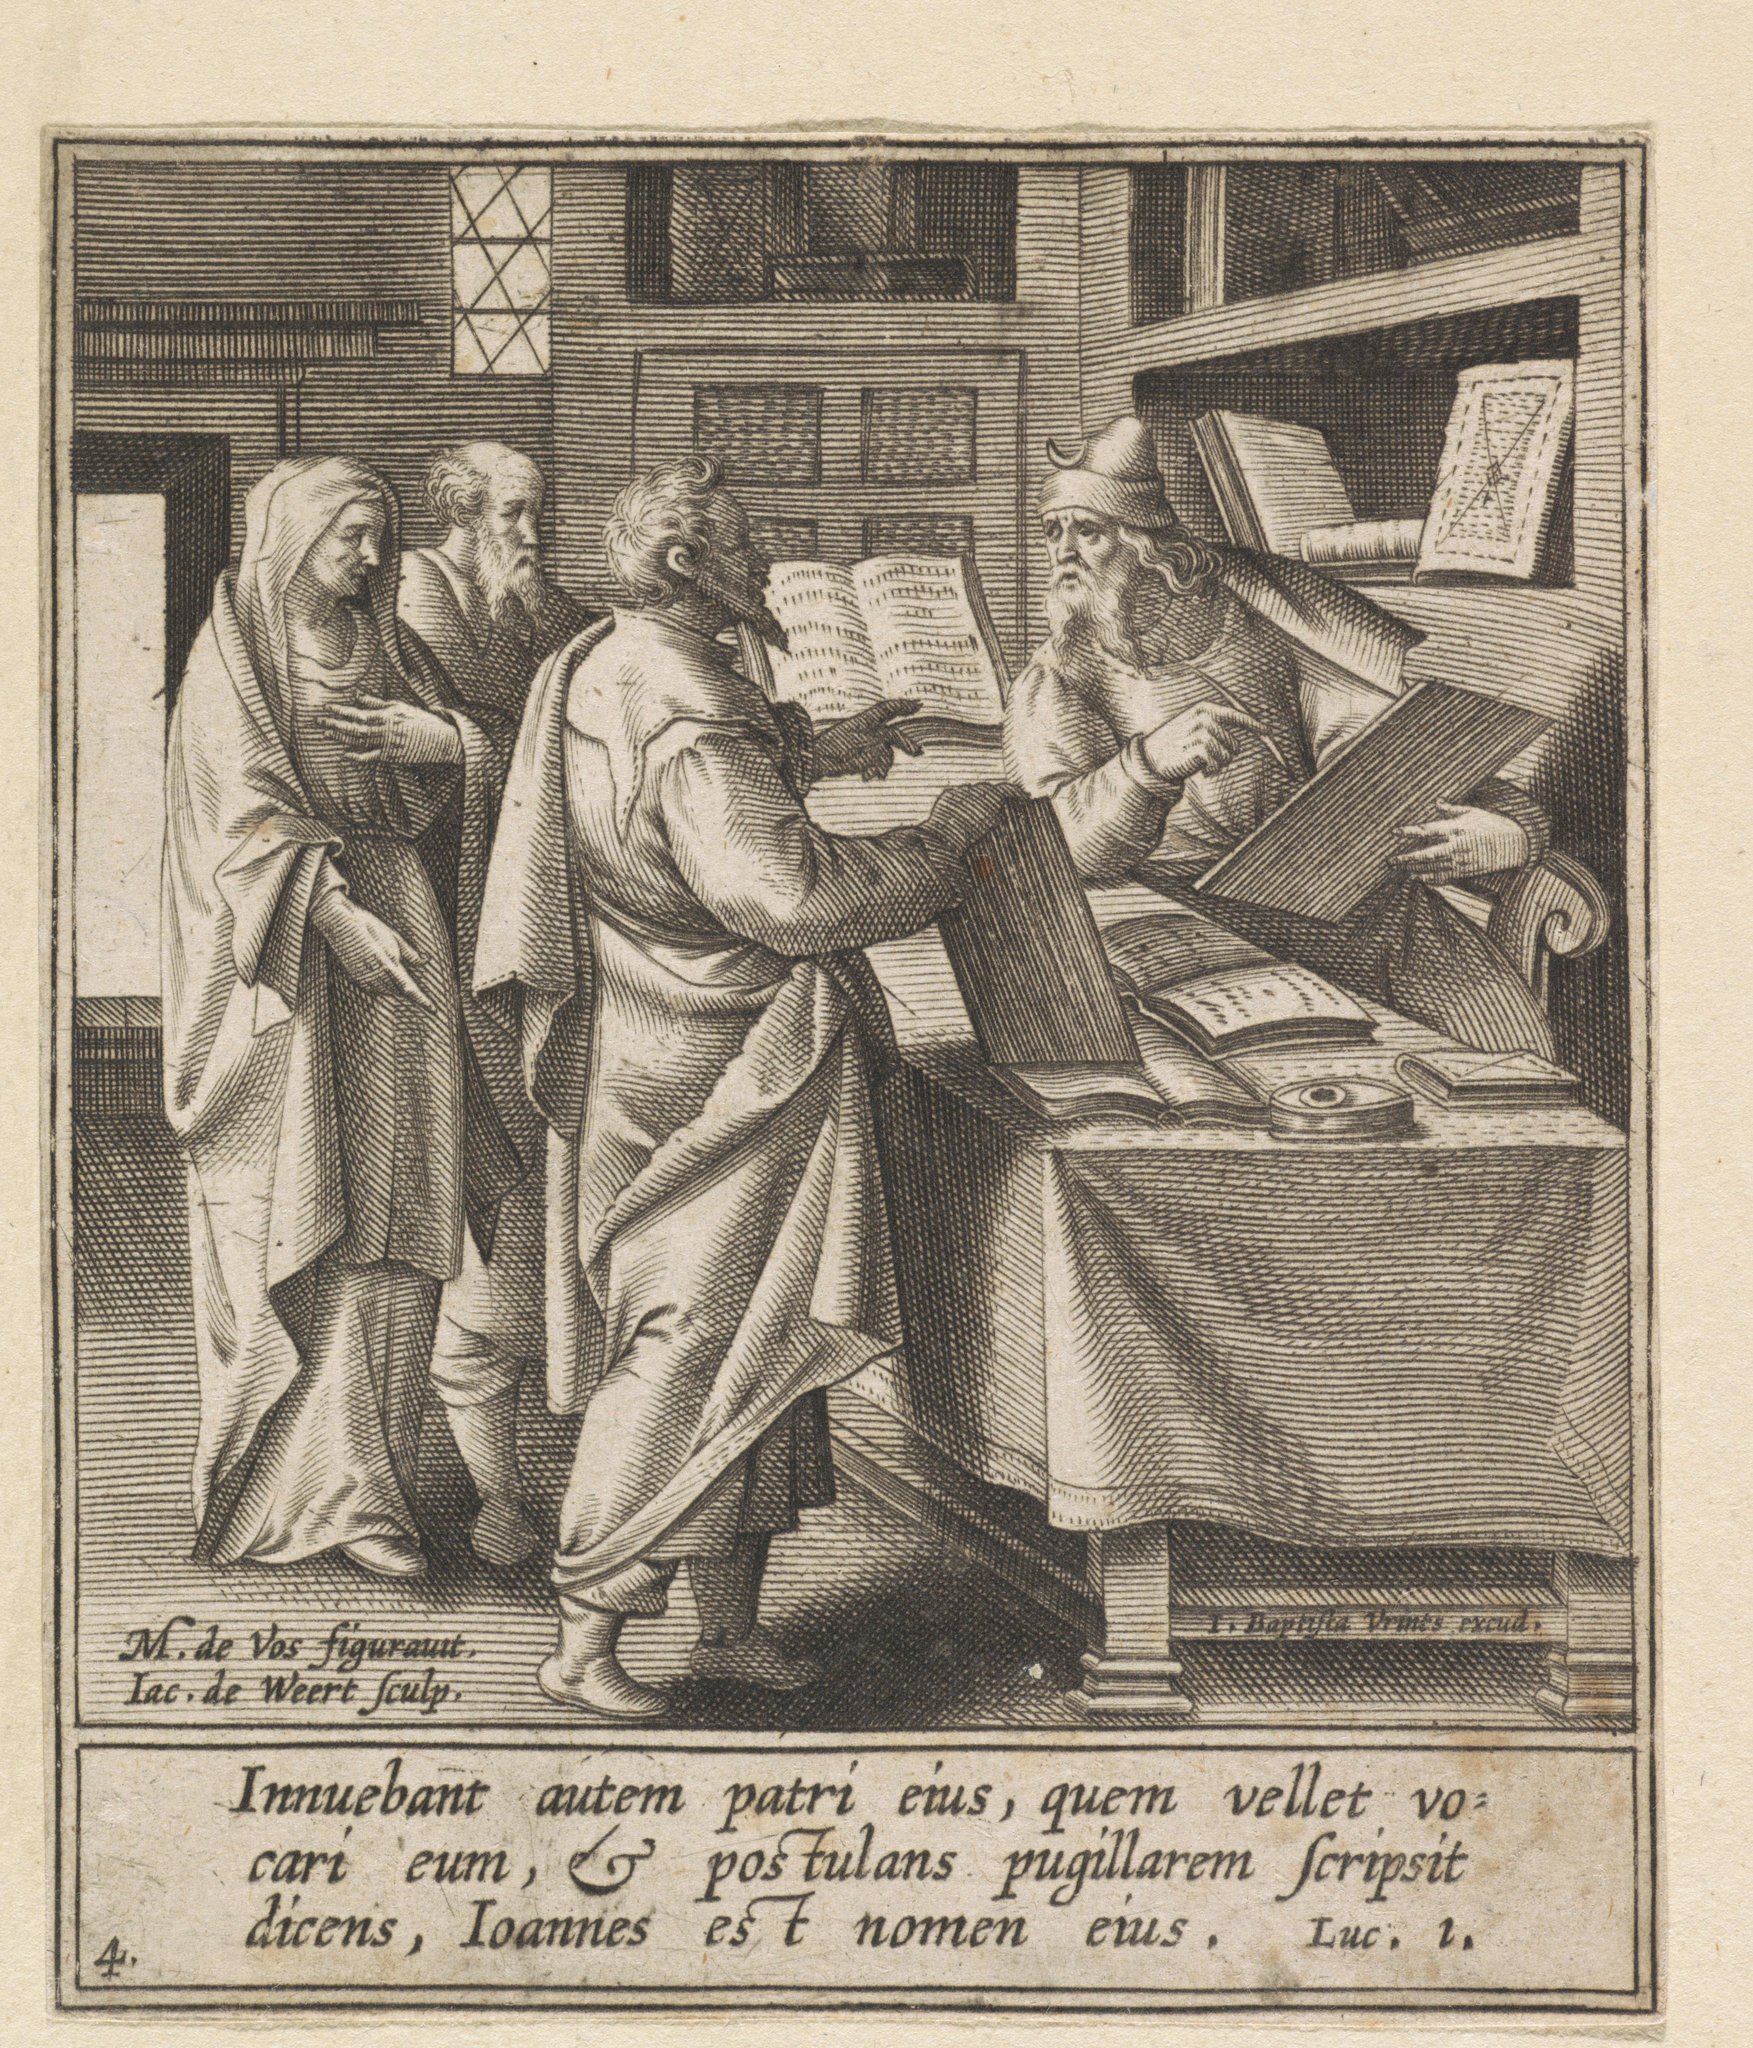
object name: print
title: Naamgeving van Johannes de Doper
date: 1580-1600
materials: paper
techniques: engraving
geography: antwerp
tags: naming of john the baptist; zacharias writing john's name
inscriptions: collector's mark: Lugt 240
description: Elisabet en twee mannen staan bij een tafel met geschriften. Achter de tafel zit vermoedelijk Zacharias met schrijfgerei en een schrijftafel. Onder de voorstelling bevindt zich een drieregelige, Latijnse tekst met de beschrijving van de scène uit Luc. 1.